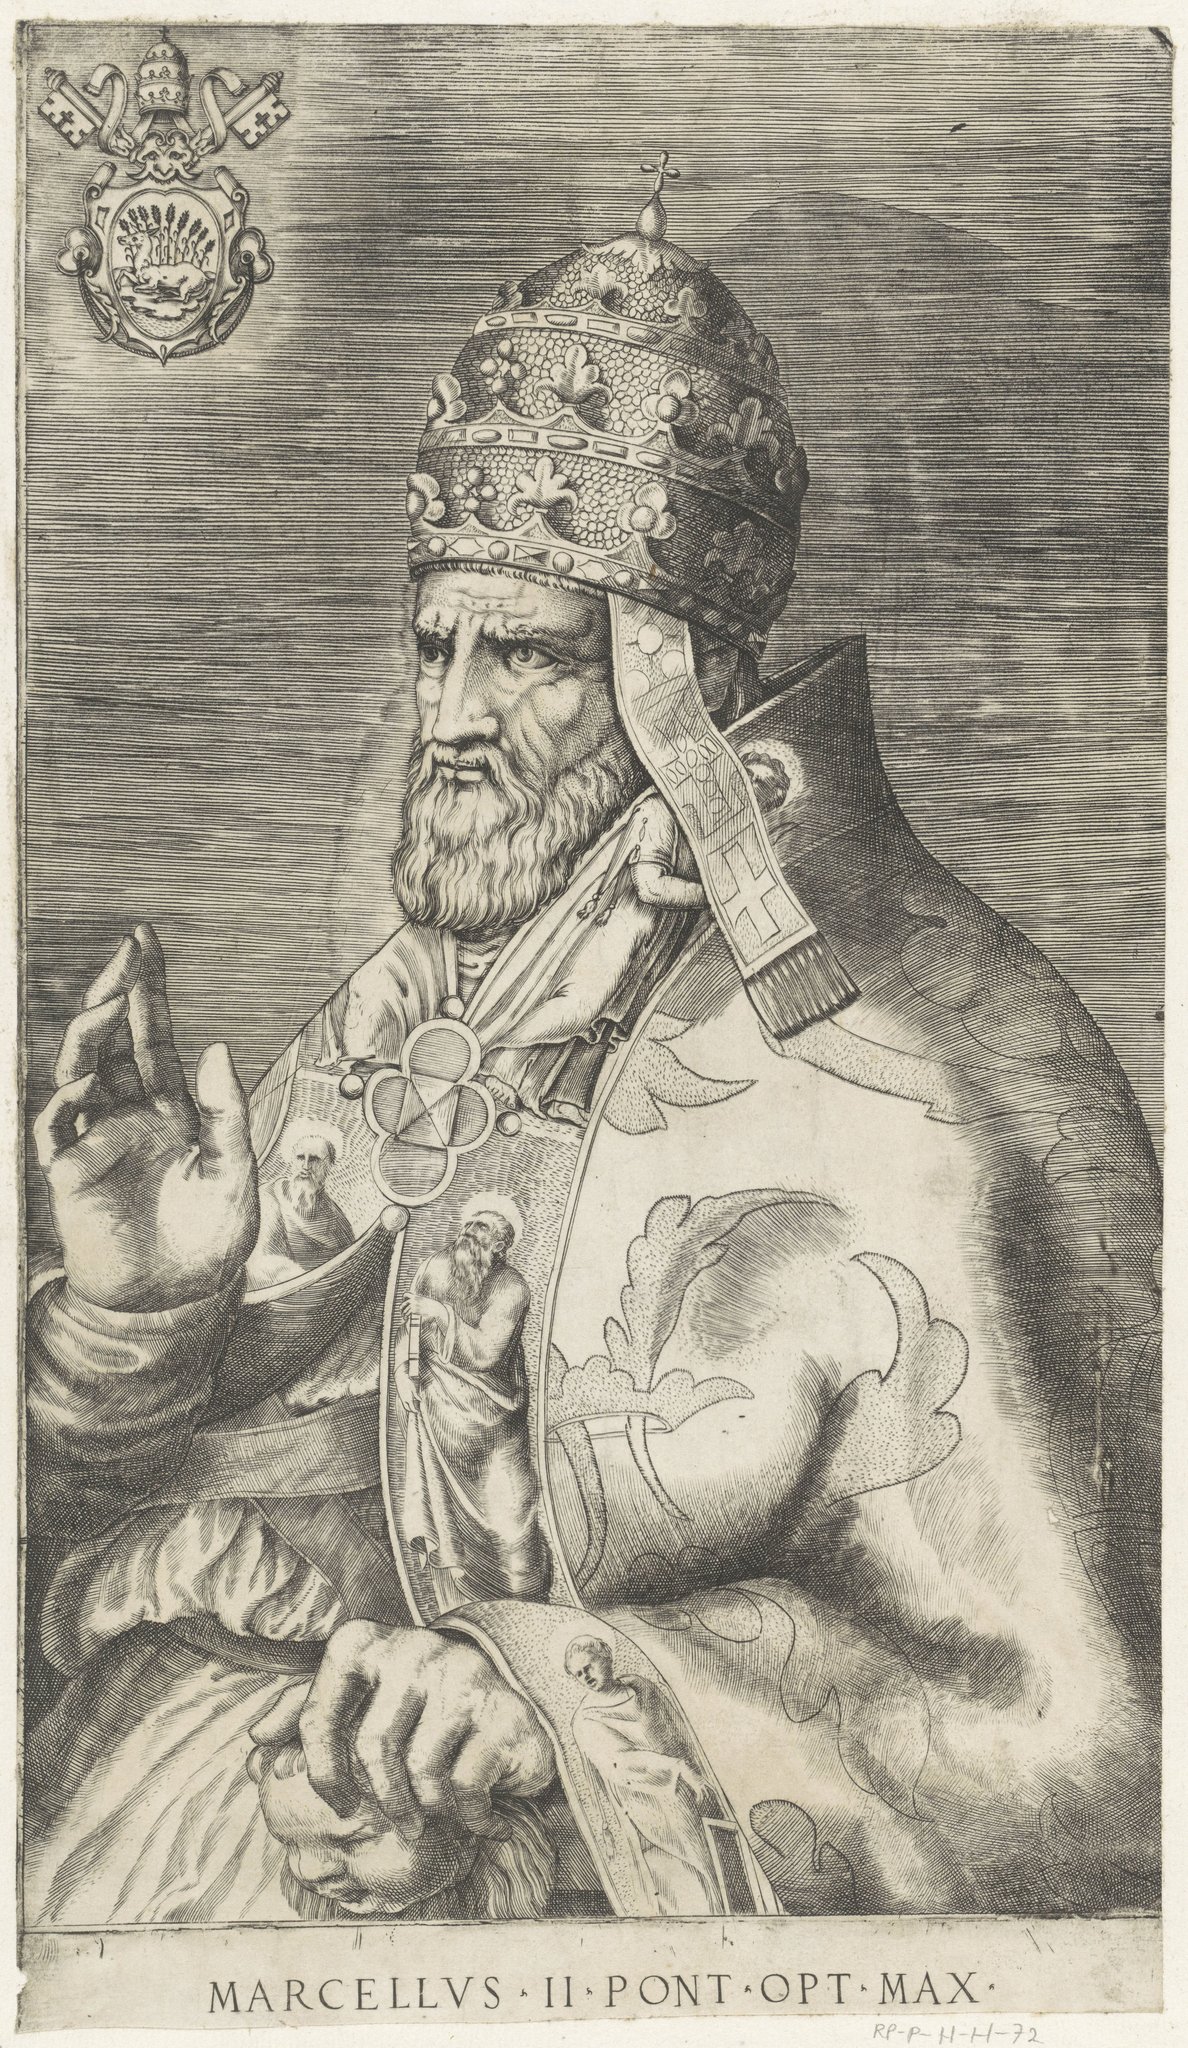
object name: print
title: Portret van paus Marcellus II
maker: giulio bonasone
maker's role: painter, print maker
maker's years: 1510-1576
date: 1501-1580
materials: paper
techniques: engraving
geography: italy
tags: historical persons, pope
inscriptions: collector's mark: ‘Hinloopen’, collector's mark: Lugt 11